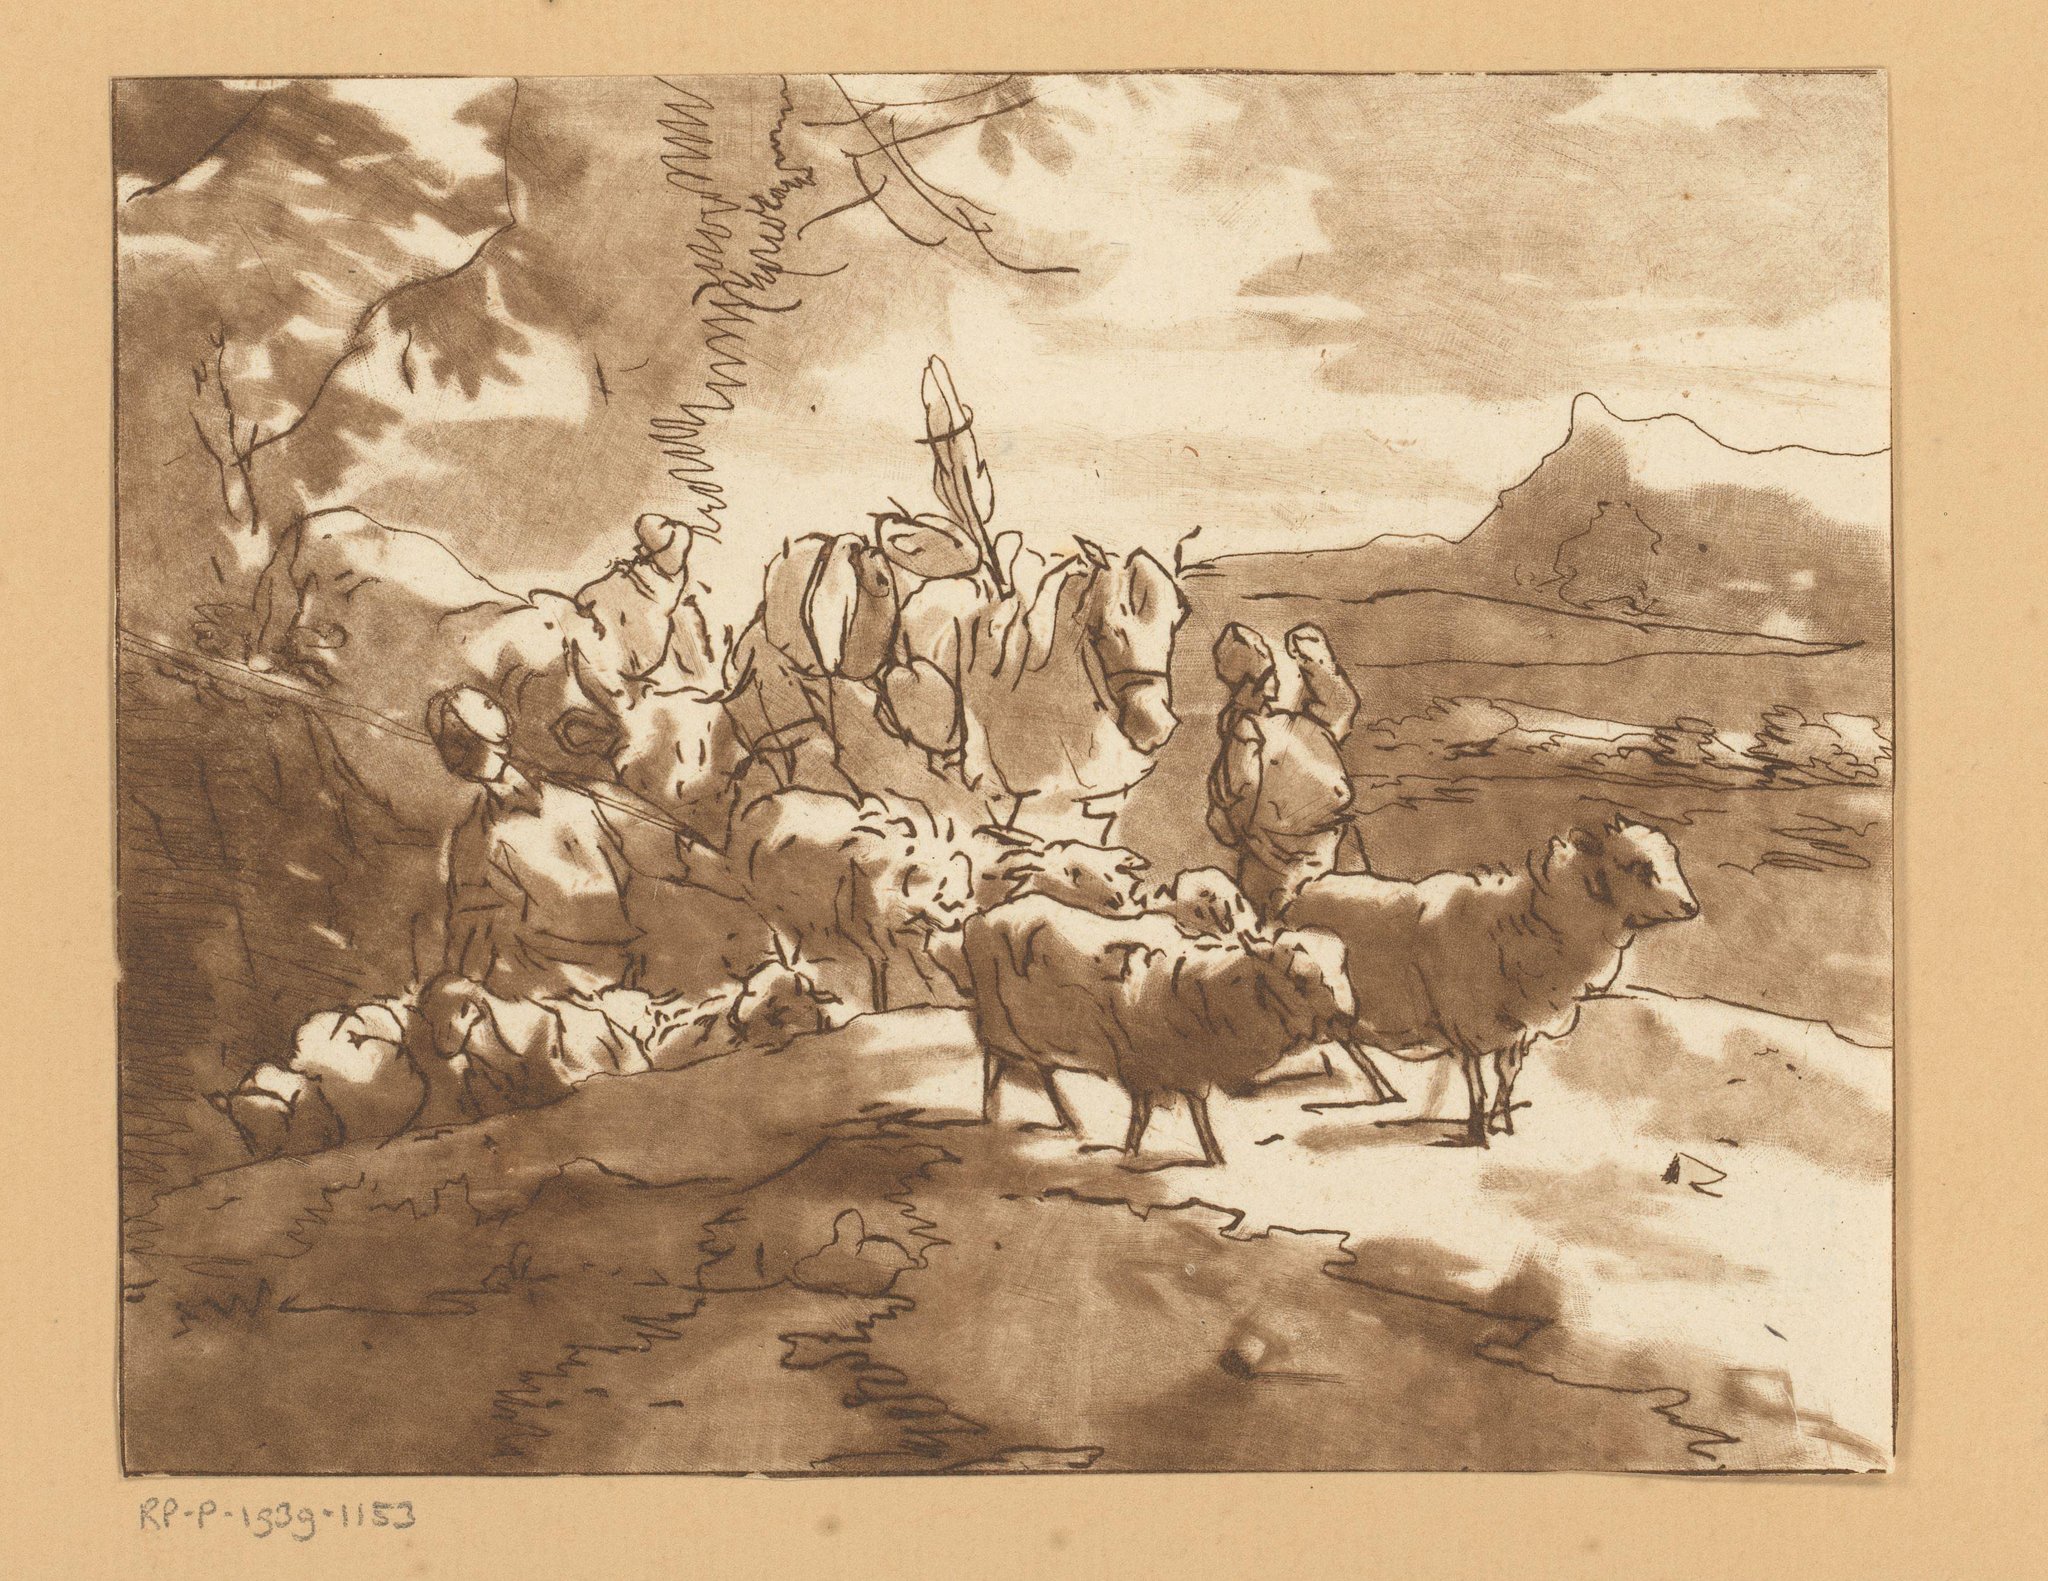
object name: print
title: Paard met kudde schapen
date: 1769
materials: paper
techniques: etching, roulette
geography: amsterdam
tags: herding, herdsman, herdswoman, shepherd, shepherdess, cowherd, etc., (high) hill, cattle driving, cattle driver, sheep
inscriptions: inscription: ‘Jacob van de Velde f./ S: v.d'...Does 1769.’, collector's mark: ‘RIJKS / MUSM’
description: De prent werd opgenomen in: Collection d'imitations de dessins d'après les principaux maîtres hollandais et flamands, Londen, C. Josi, 1821.